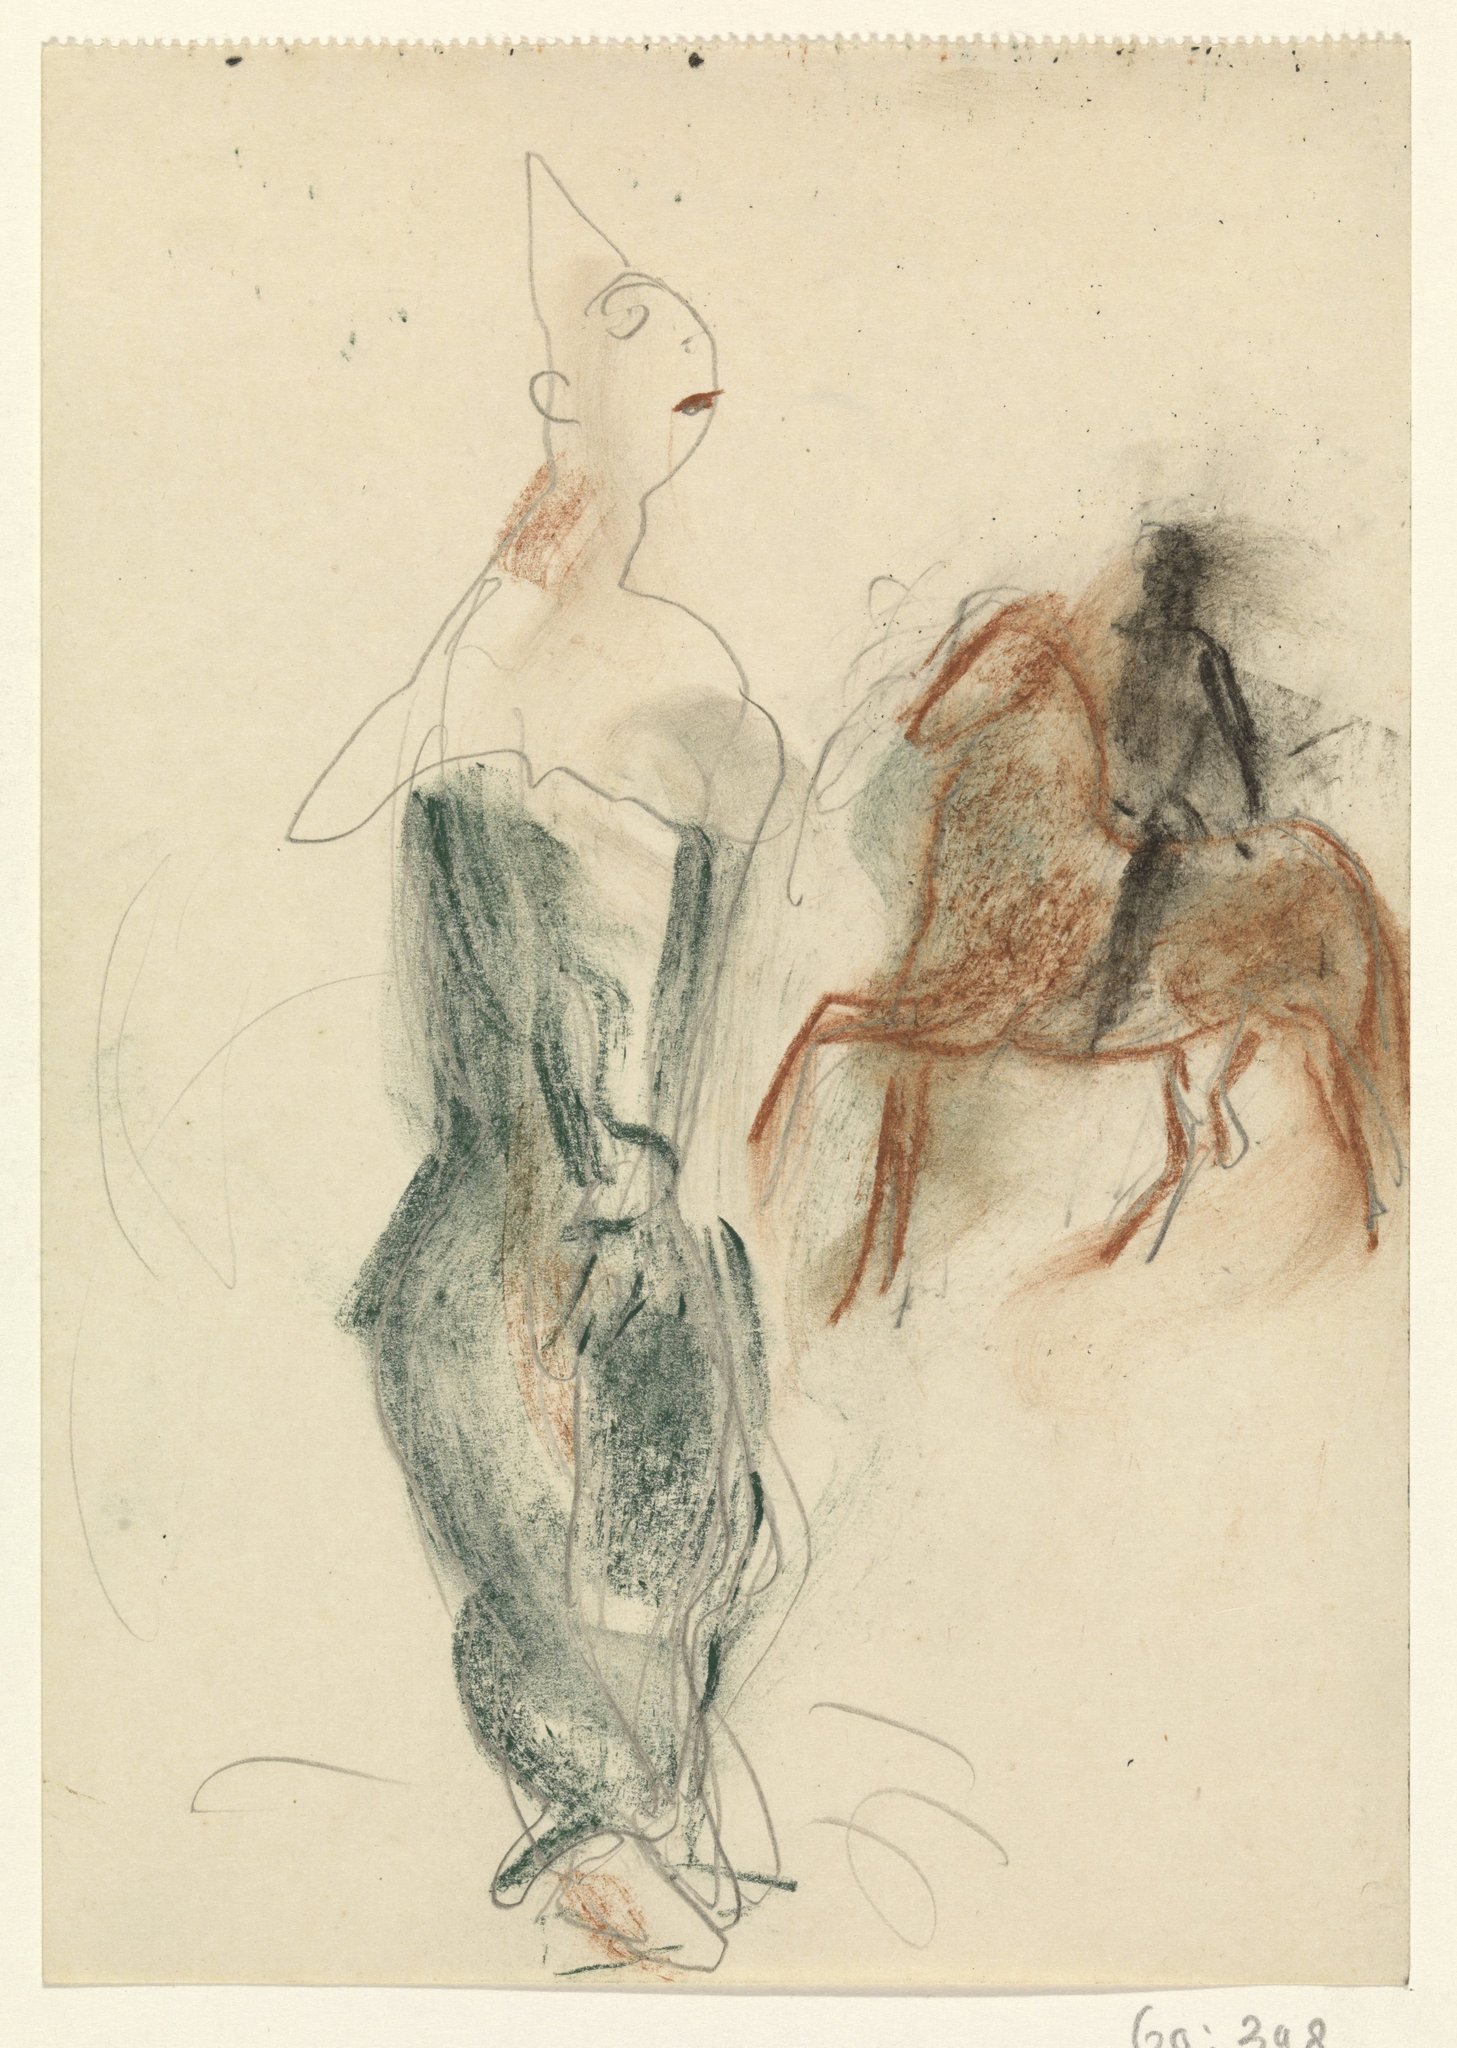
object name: drawing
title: Clown en ruiter te paard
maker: leo gestel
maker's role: draughtsman, print maker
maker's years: 1881-1941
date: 1891-1941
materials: chalk, paper, pencil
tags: riding a horse, ass, or mule; rider, horseman, clown, horse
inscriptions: collector's mark: Lugt 2228